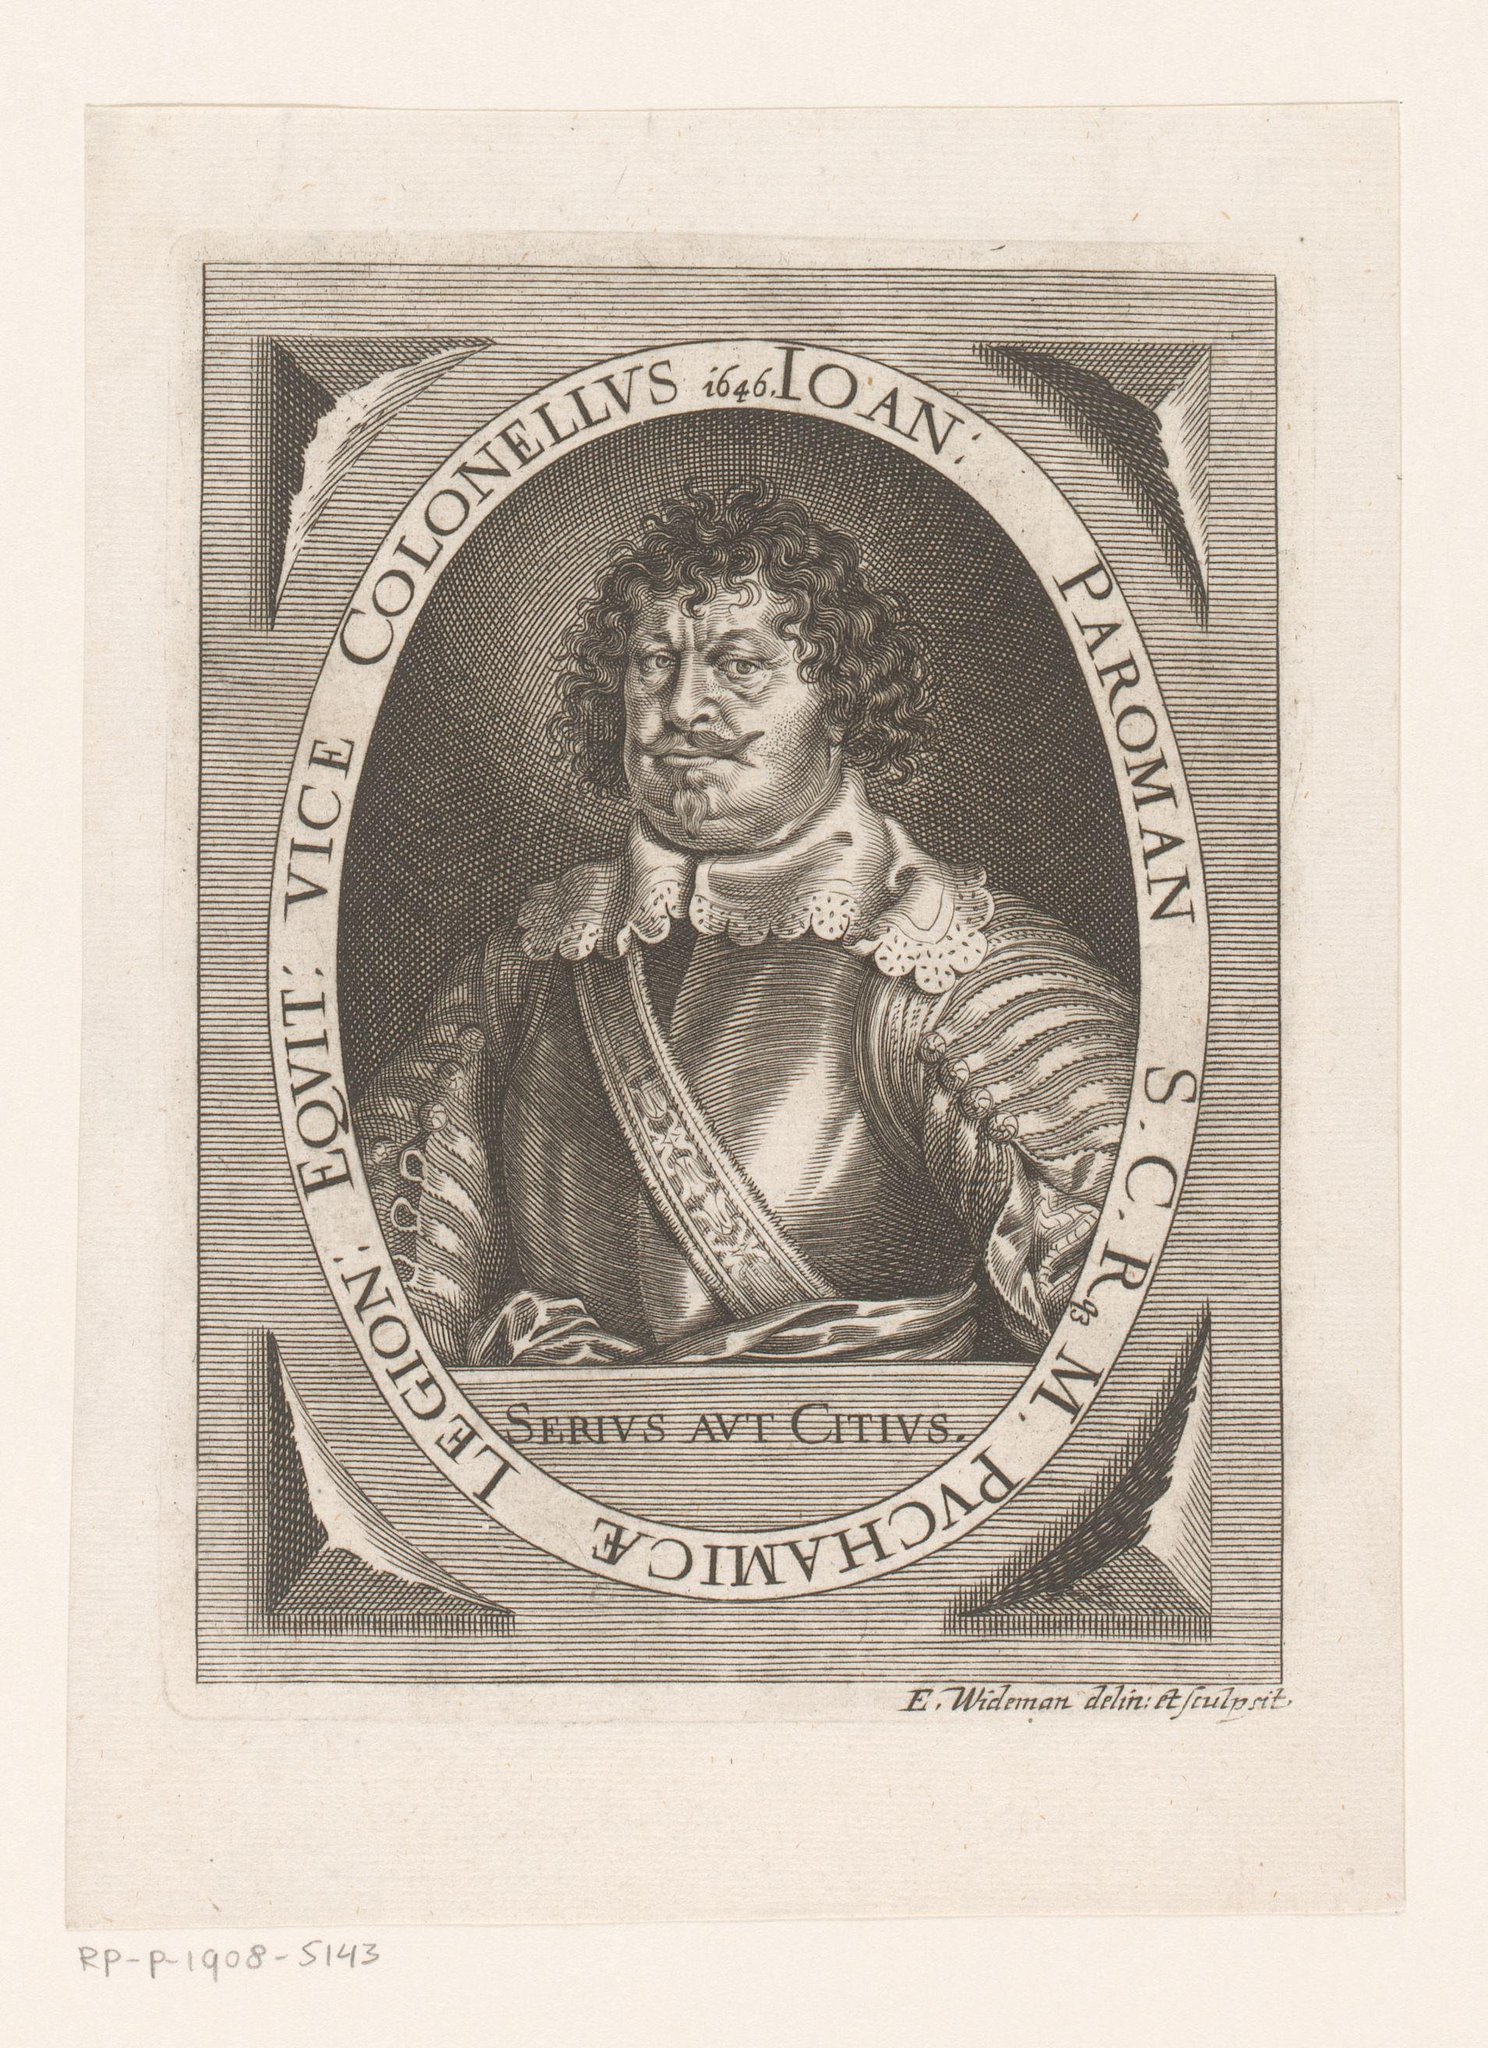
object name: print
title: Portret van Johann Paroman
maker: elias widemann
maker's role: print maker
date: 1646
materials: paper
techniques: engraving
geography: vienna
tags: historical persons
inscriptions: collector's mark: Lugt 2228